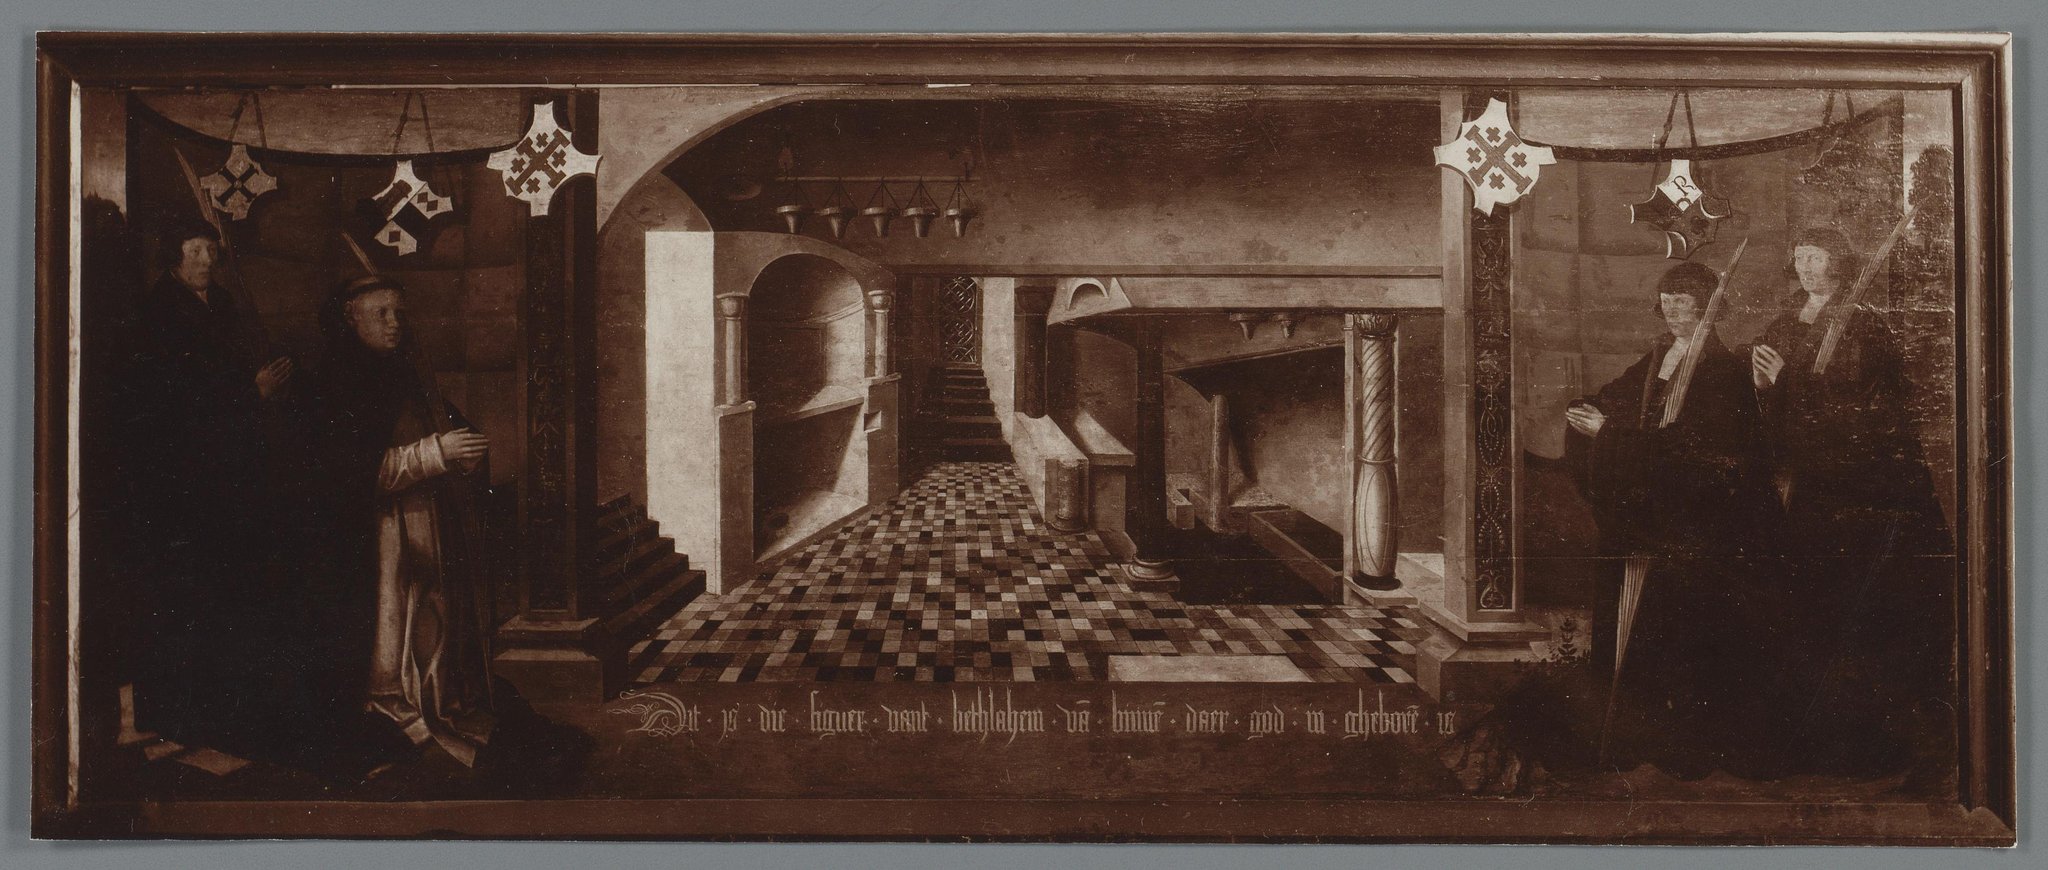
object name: photograph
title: Fotoreproductie van schilderij van vier biddende personen bij een interieur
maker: Anonymous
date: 1880-1920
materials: paper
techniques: collodion silver print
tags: (private) prayer; 'oratione', 'preghiere', 'preghiere a dio' (ripa), interior of the house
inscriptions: number: ‘230.’